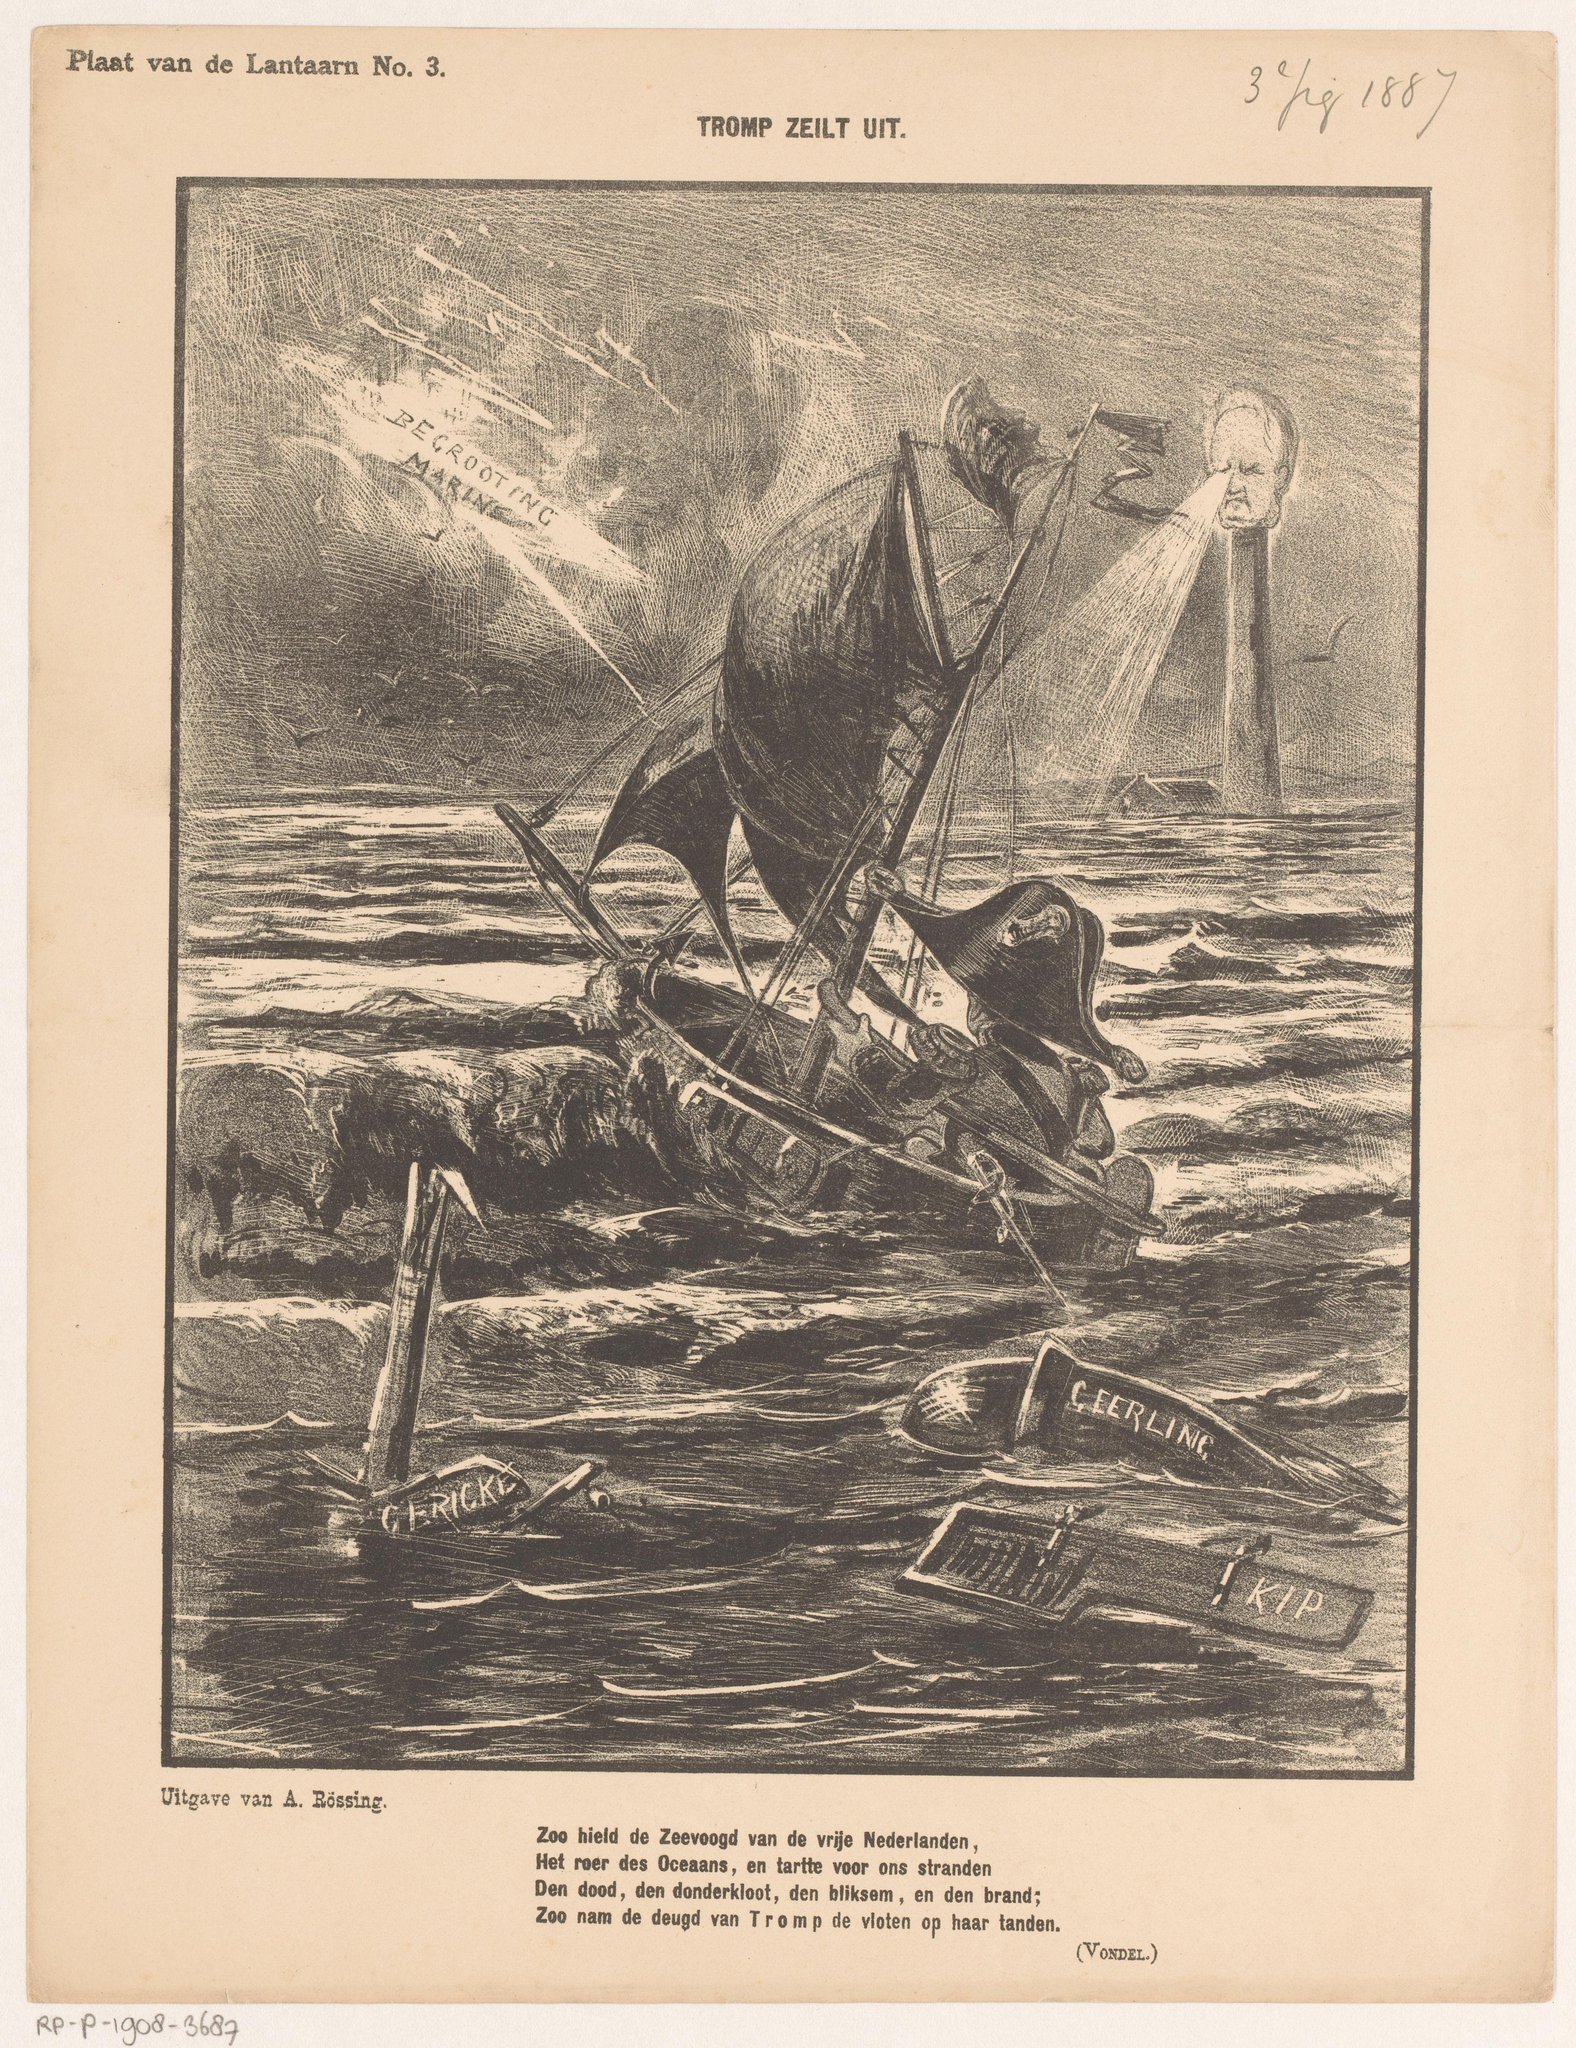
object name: cartoon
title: Spotprent met een boot op zee in noodweer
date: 1887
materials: paper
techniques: lithograph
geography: netherlands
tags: flushing, sailing-ship, sailing-boat (+ wreck ~ traffic accident), storm at sea, political caricatures and satires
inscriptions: collector's mark: Lugt 2228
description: Minister Tromp, in de vorm van een vuurtoren, schijnt licht op de zeilboot. In de lucht een bliksemflits met de woorden 'Begrooting Marine'. In het water drijven stukken wrakhout met de namen van voorgaande ministers van Marine. Onder de afbeelding een bijschrift afkomstig van een portret van Maarten Harpertsz. Tromp uit 1653 door Joost van den Vondel. Deze prent werd uitgegeven bij De Lantaarn.